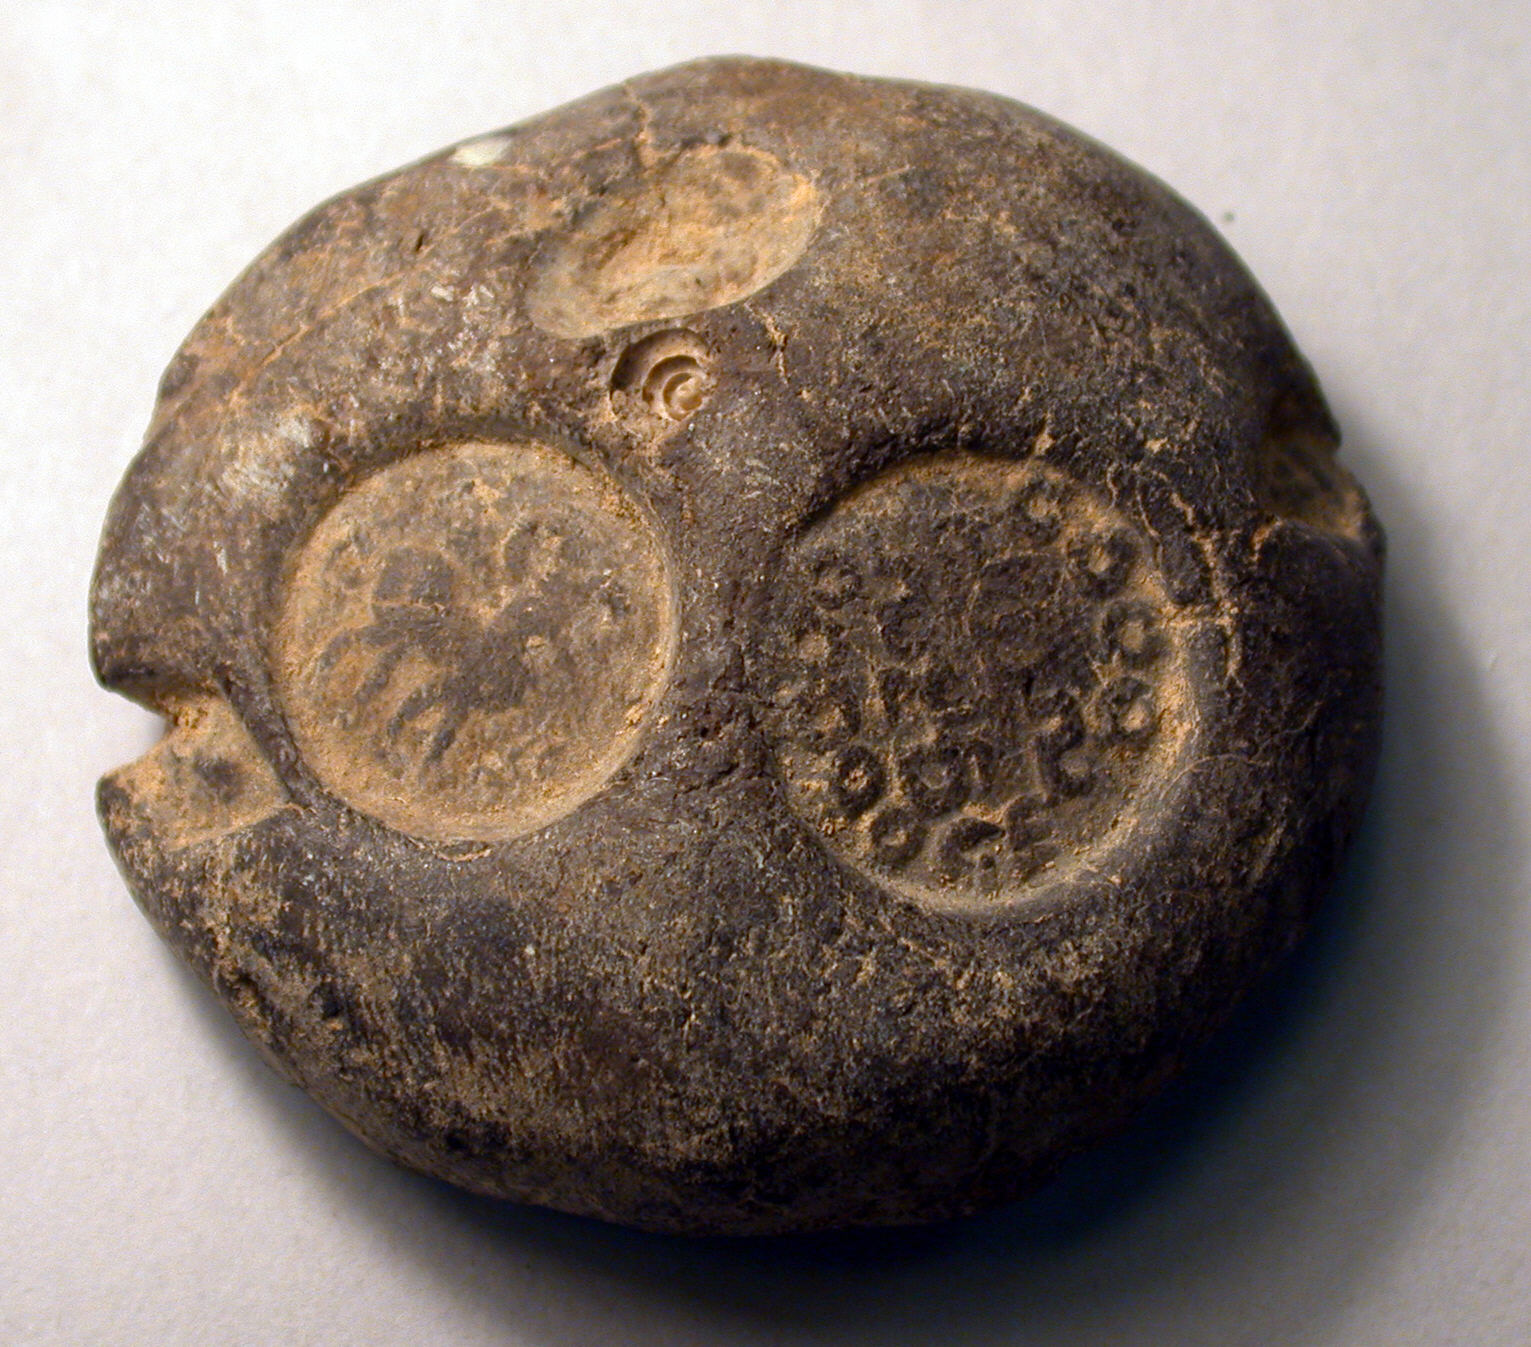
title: Bulla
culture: sasanian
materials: clay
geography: iran